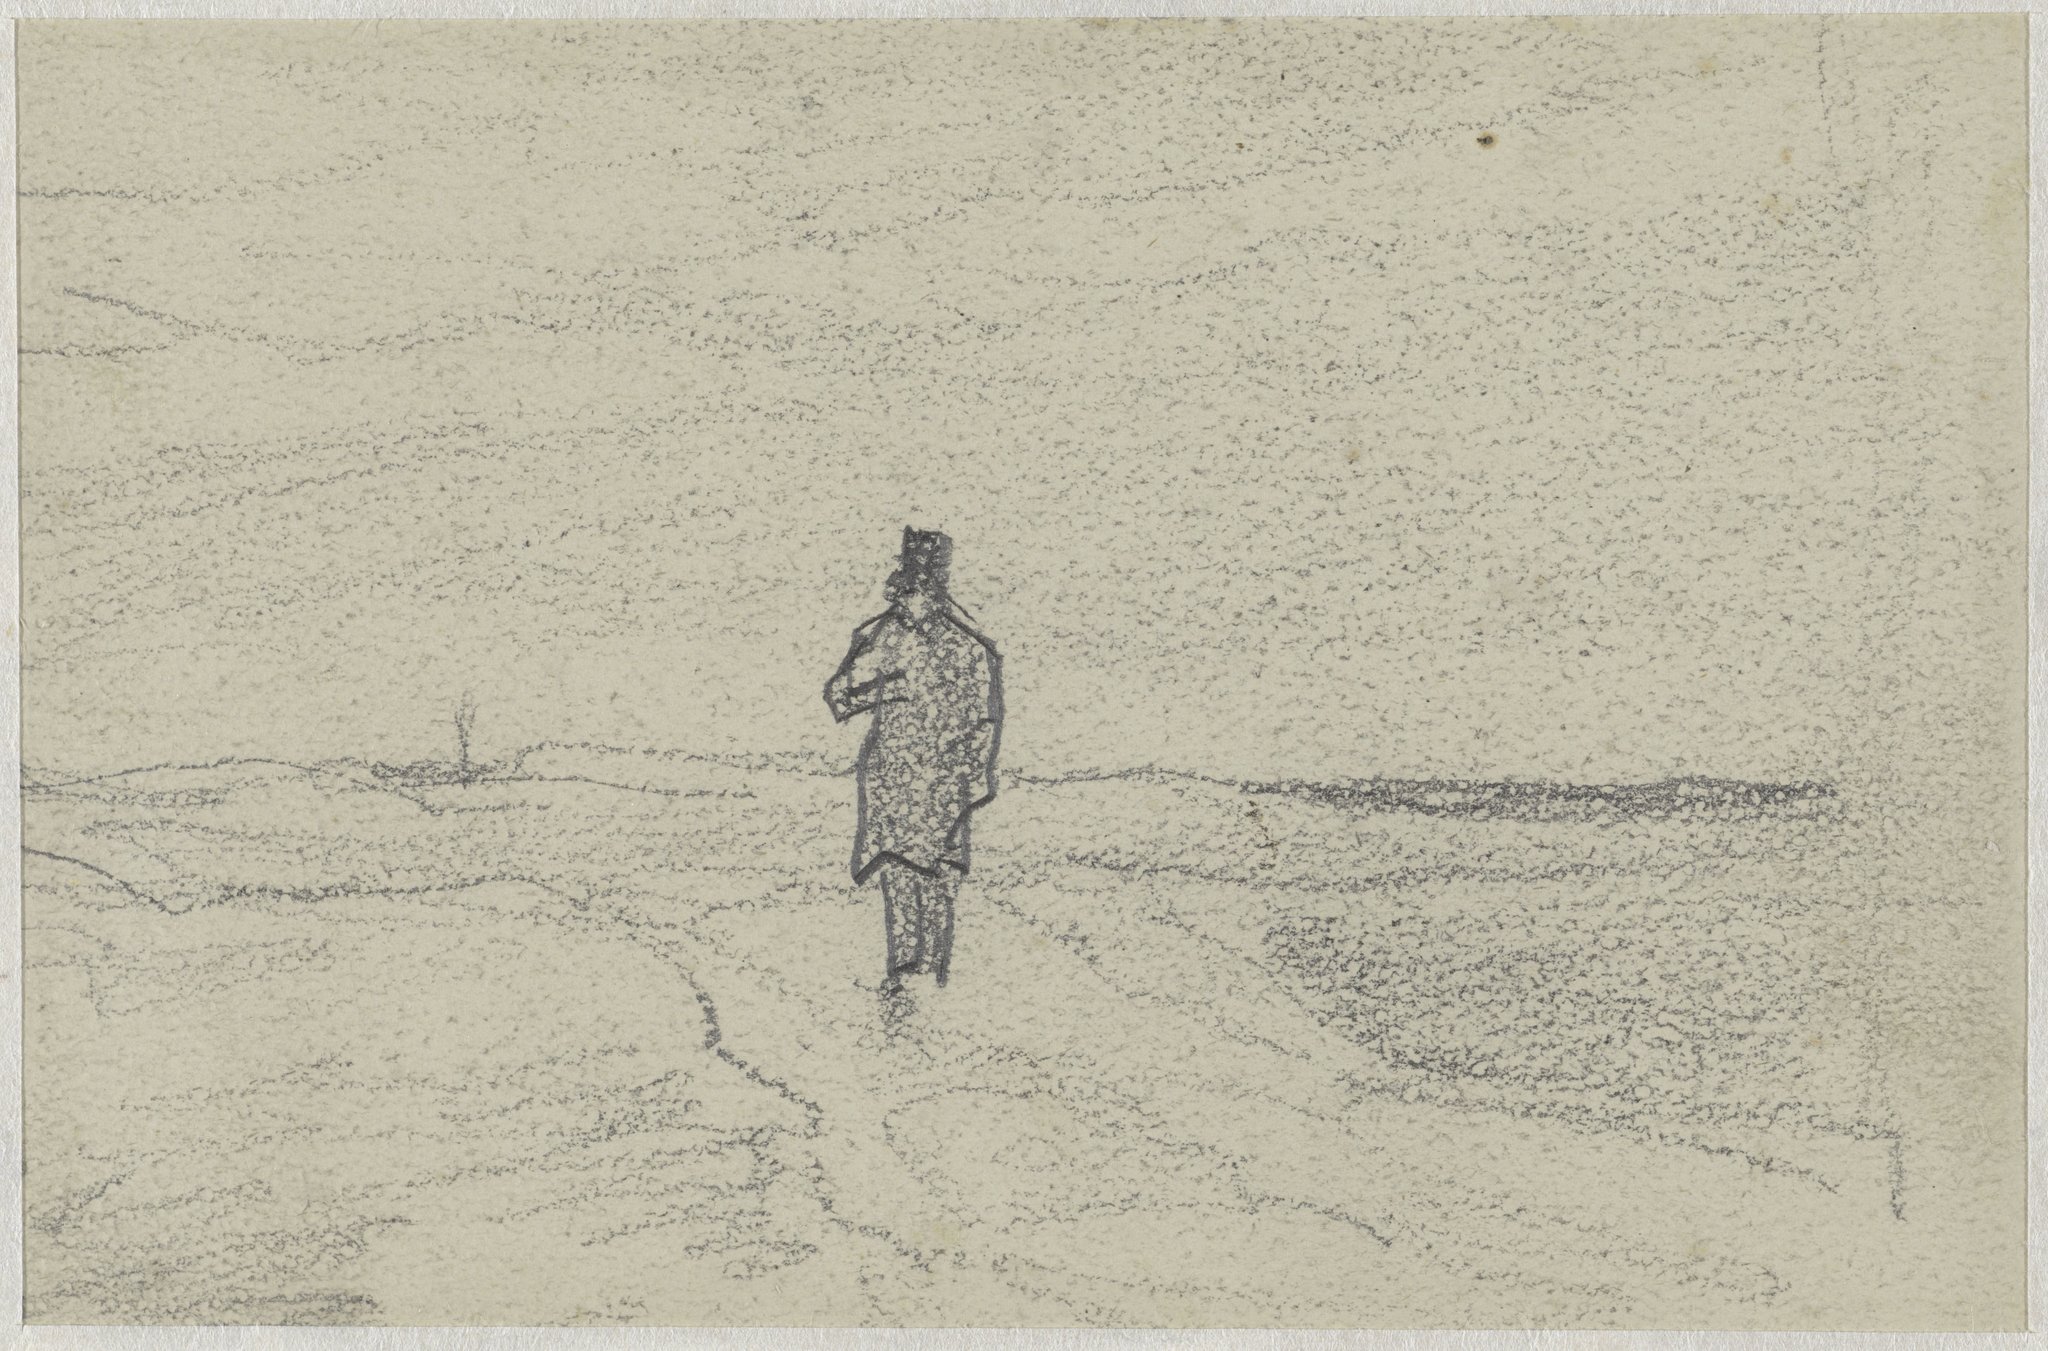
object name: drawing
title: Landschap met een wandelaar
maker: anton mauve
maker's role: draughtsman, painter, print maker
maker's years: 1838-1888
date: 1848-1888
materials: paper, pencil